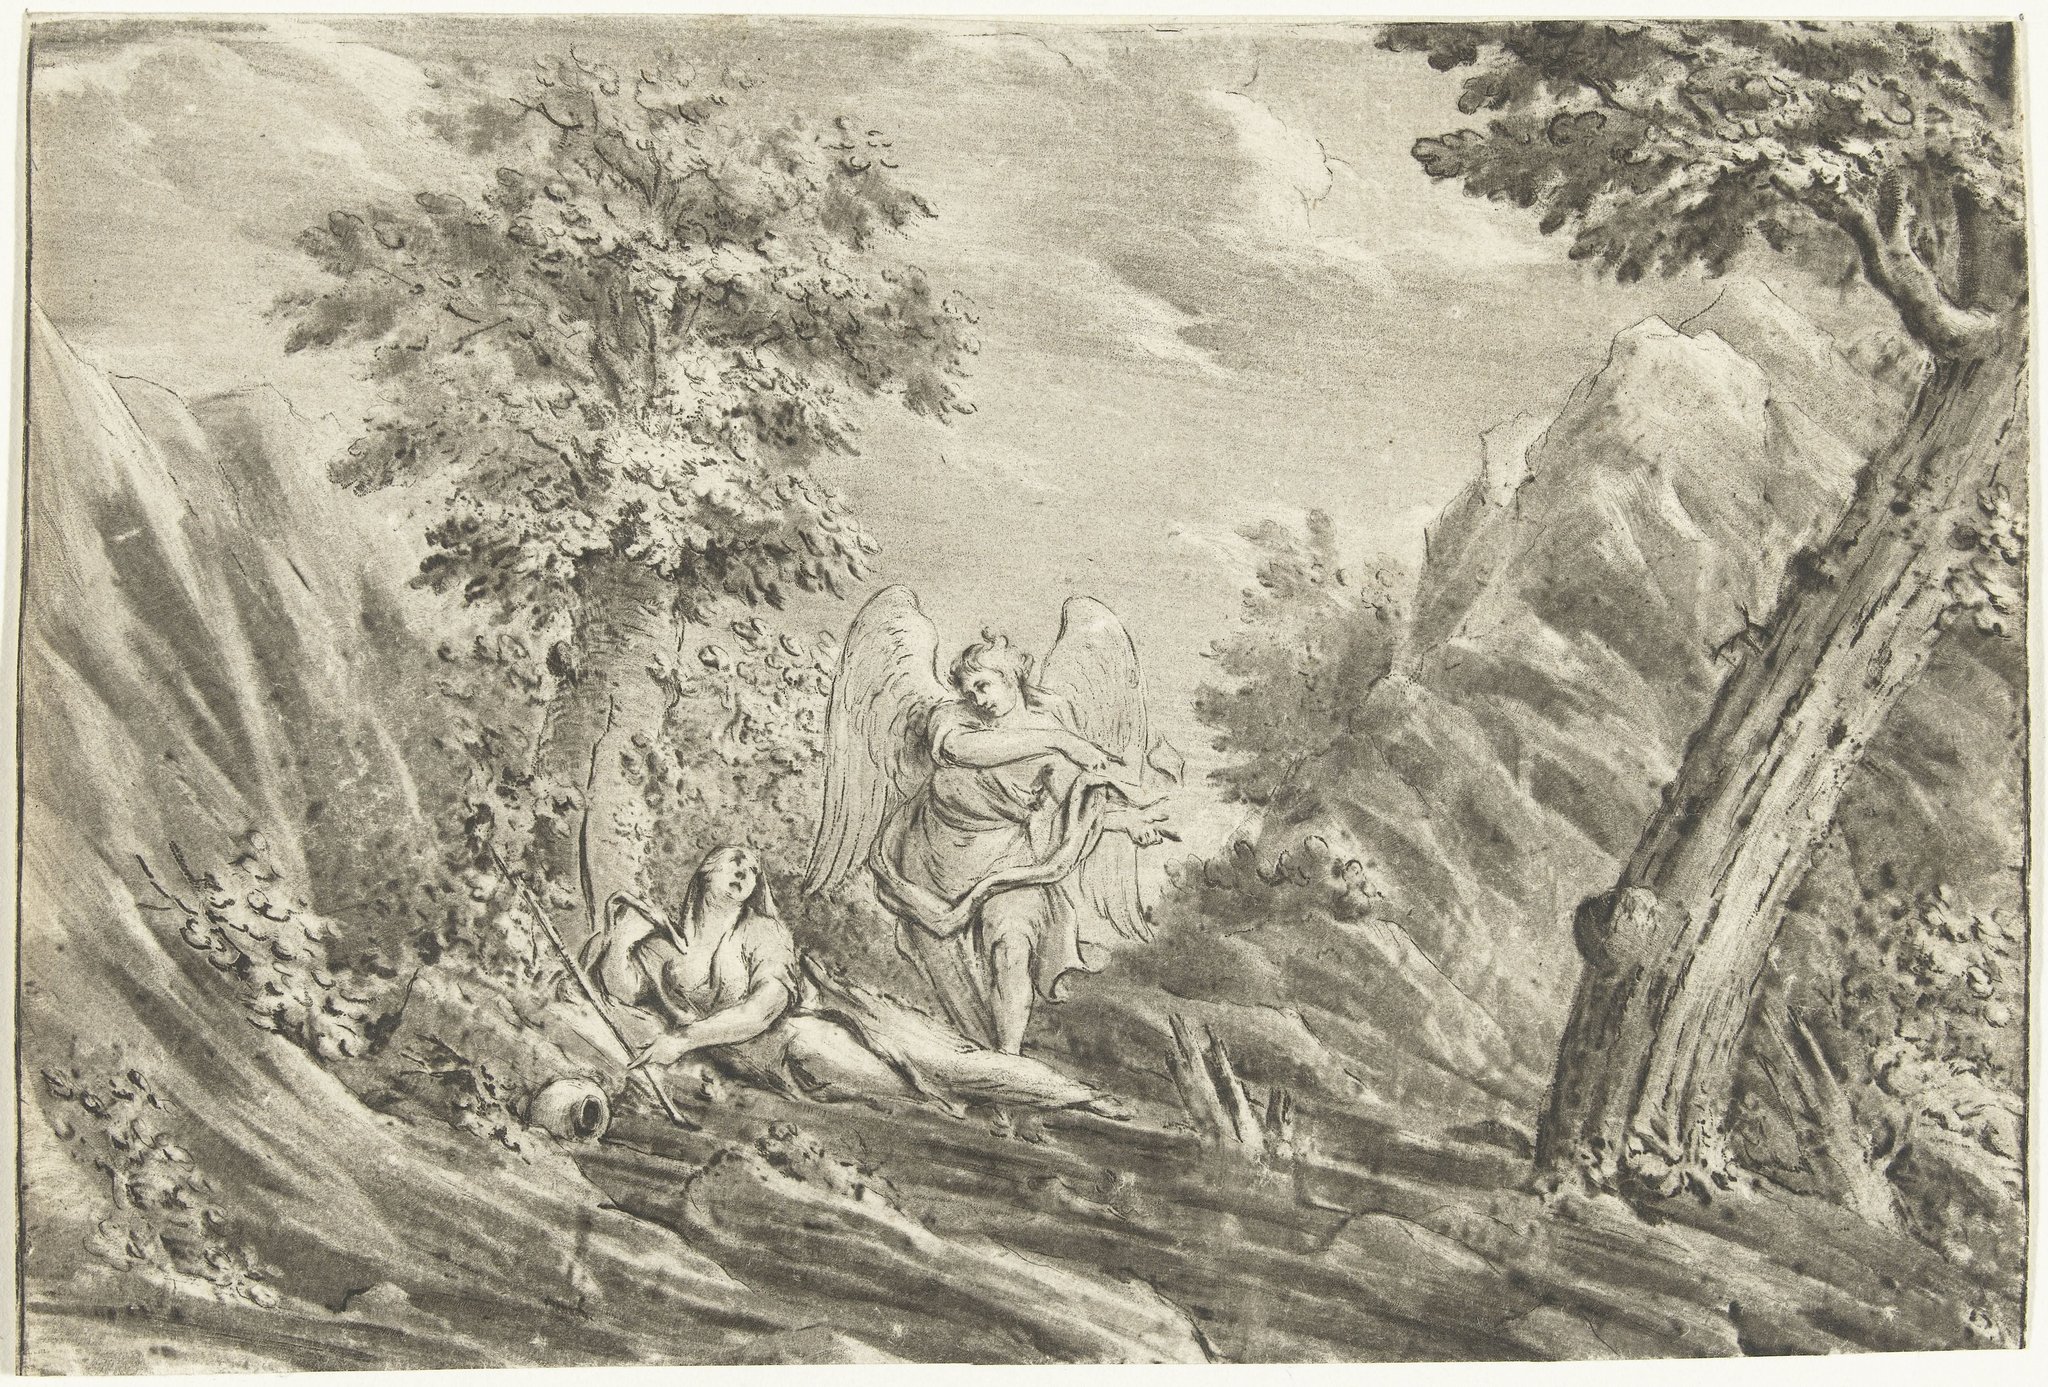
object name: print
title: Hagar in de woestijn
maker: jurriaan cootwijck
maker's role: print maker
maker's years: 1714-1798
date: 1759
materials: paper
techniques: print drawing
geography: paris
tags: an angel appears and reveals a well of water to hagar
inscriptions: collector's mark: Lugt 2228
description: Hagar ligt op de grond in een bergachtig landschap. Een engel wijst haar naar een waterbron. Rechts ligt Ismaël, het kind van Hagar, verscholen onder een struik.